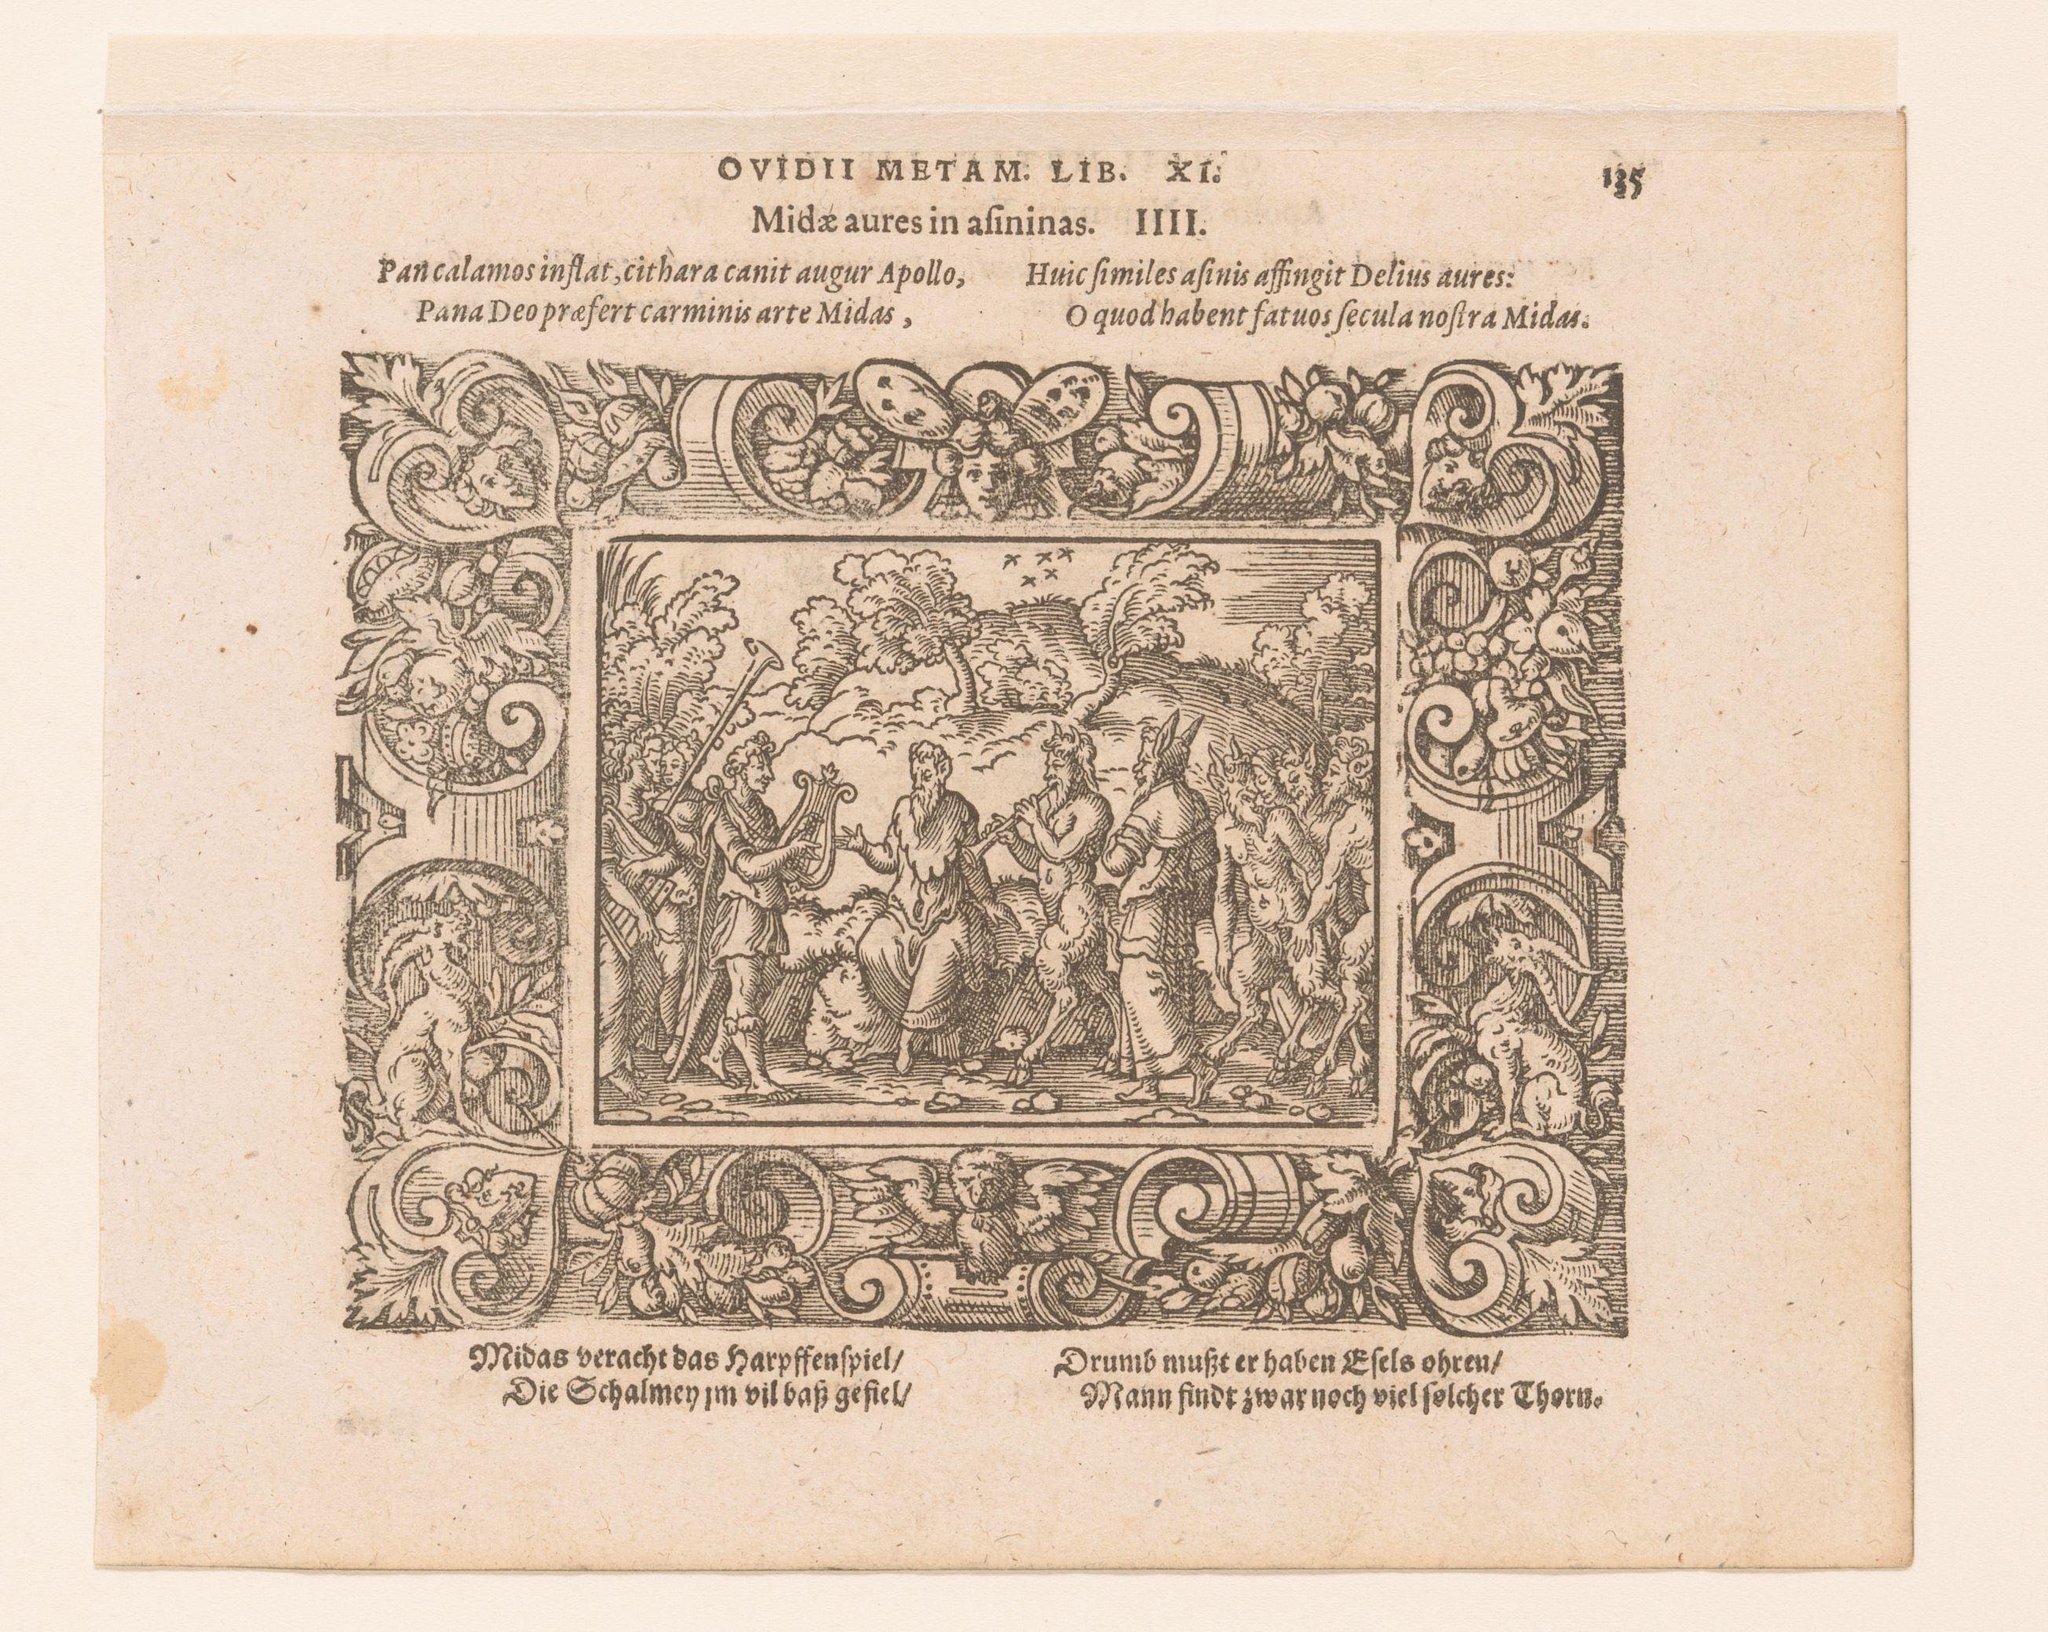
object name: book illustration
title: Midae aures in asininas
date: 1569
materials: paper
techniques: letterpress printing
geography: frankfurt am main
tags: scrollwork, strapwork ~ ornament, midas given ass's ears: apollo gives midas ass's ears as punishment for preferring pan in the musical contest between apollo and pan (ovid, metamorphoses xi 174), contest between apollo and pan with the mountain god tmolus as judge, i.e. judgement of midas; midas often represented with ass's ears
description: Illustratie bij de Metamorfosen van Ovidius, afkomstig uit de publicatie: Posthius, Johannes. Tetrasticha in Ovidii metam. Frankfurt am Main: Georg Rab en Sigmund Feyerabend en erven Weigand Han, 1569. De voorstellingen en ornamentranden van deze boekillustraties zijn van twee aparte blokken gedrukt. Beide werden afzonderlijk van elkaar ook gebruikt voor andere publicaties, en de ornamentranden werden eveneens binnen deze publicatie meerdere keren gebruikt.